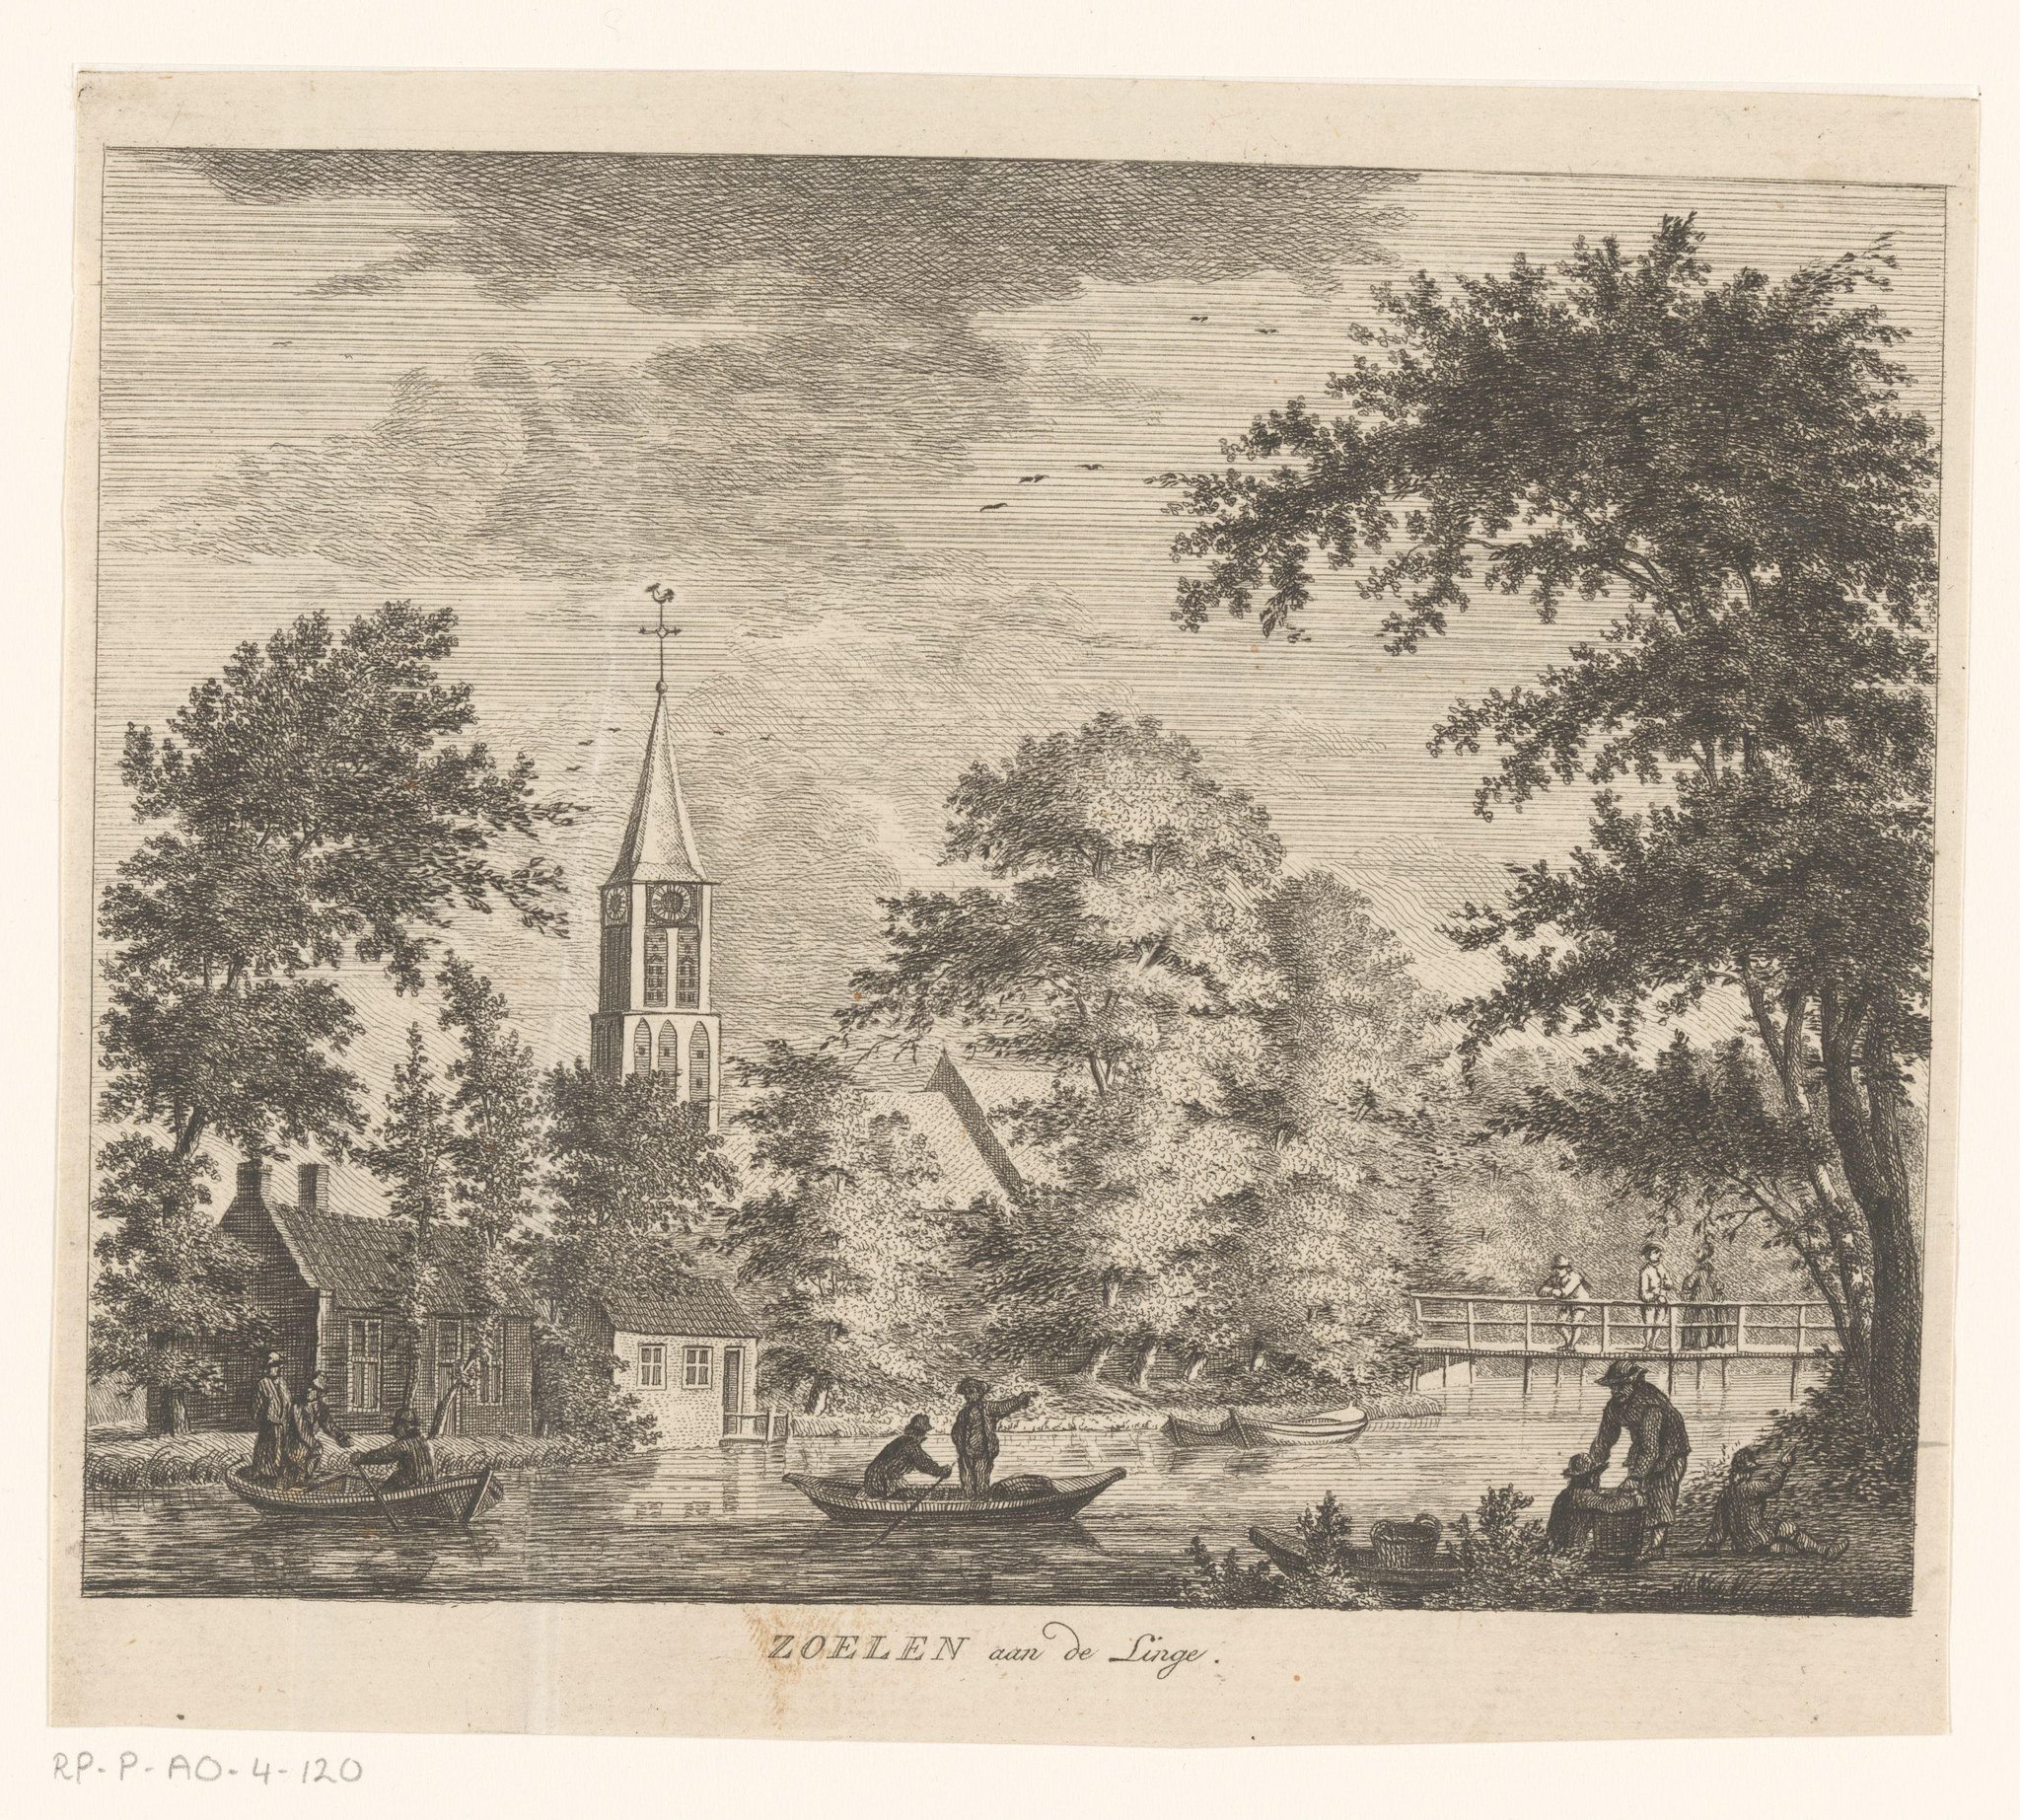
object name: print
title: Gezicht op Zoelen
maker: Anonymous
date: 1760-1800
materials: paper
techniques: engraving, etching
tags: prospect of village, silhouette of village, church (exterior)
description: Deze prent is eerst verschenen in een reeks van twaalf prenten uitgegeven door Pierre Fouquet junior in de tweede helft van de achttiende eeuw. Deze reeks bestond uit prenten van: Slot Zuylen (2x), het dorp Maarssen (3x), Deil, de Laatste Stuiver bij Houten, Het Zwarte Varken bij Maarsseveen, Oud Rome bij Haarlem, Overveen, Zoelen en de Hommelbrug bij Oudenrijn. Later zijn deze prenten gebruikt in: Gezigten van voornaame Hollandsche dorpen. Amsterdam: Evert Maaskamp, s.a. [ca. 1775-1800].